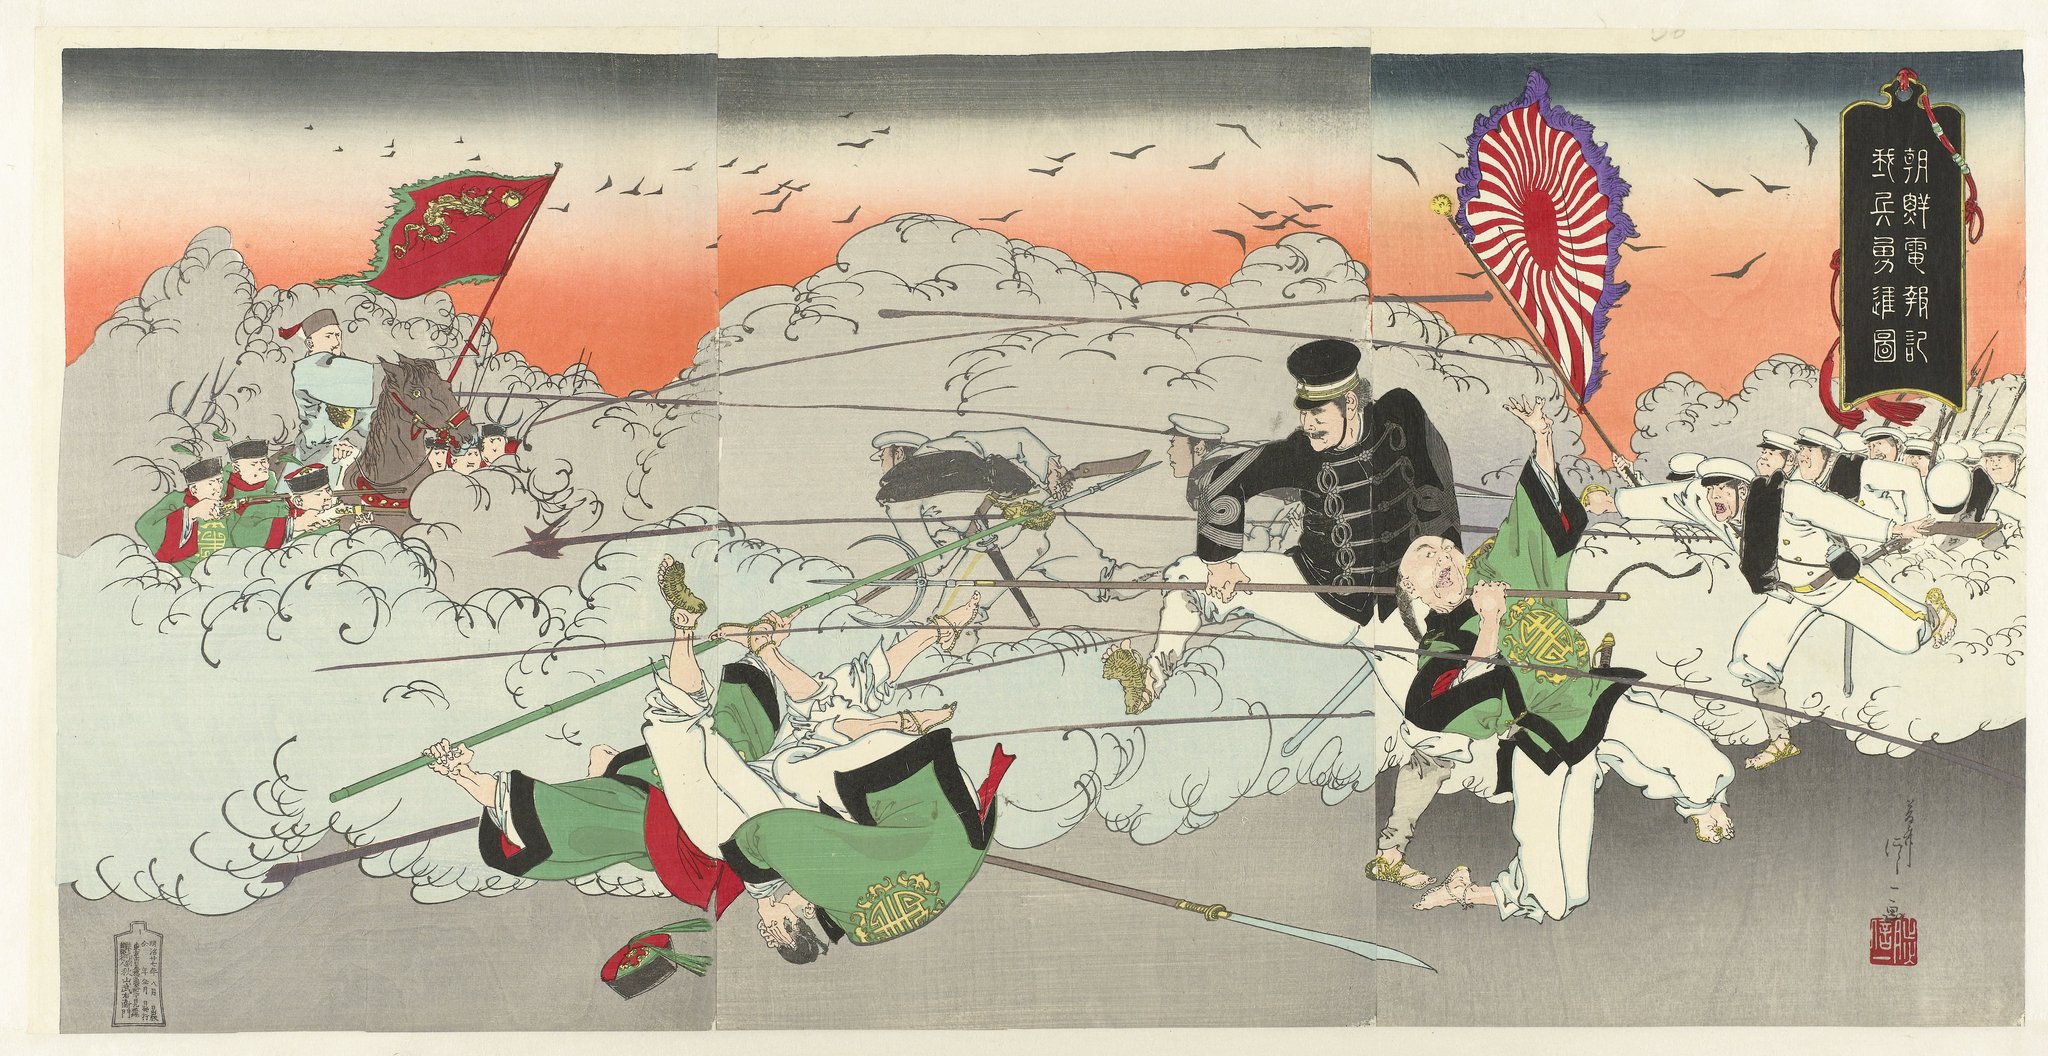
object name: triptych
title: Chôsen denpôki wahei yûshin no zu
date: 1894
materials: paper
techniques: woodcut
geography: japan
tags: battle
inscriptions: label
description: Het Japanse leger gekleed in wit uniform valt de Koreanen aan tijdens de gevechten in juli 1894 van de Eerste Chinees-Japanse Oorlog (1894-1895).